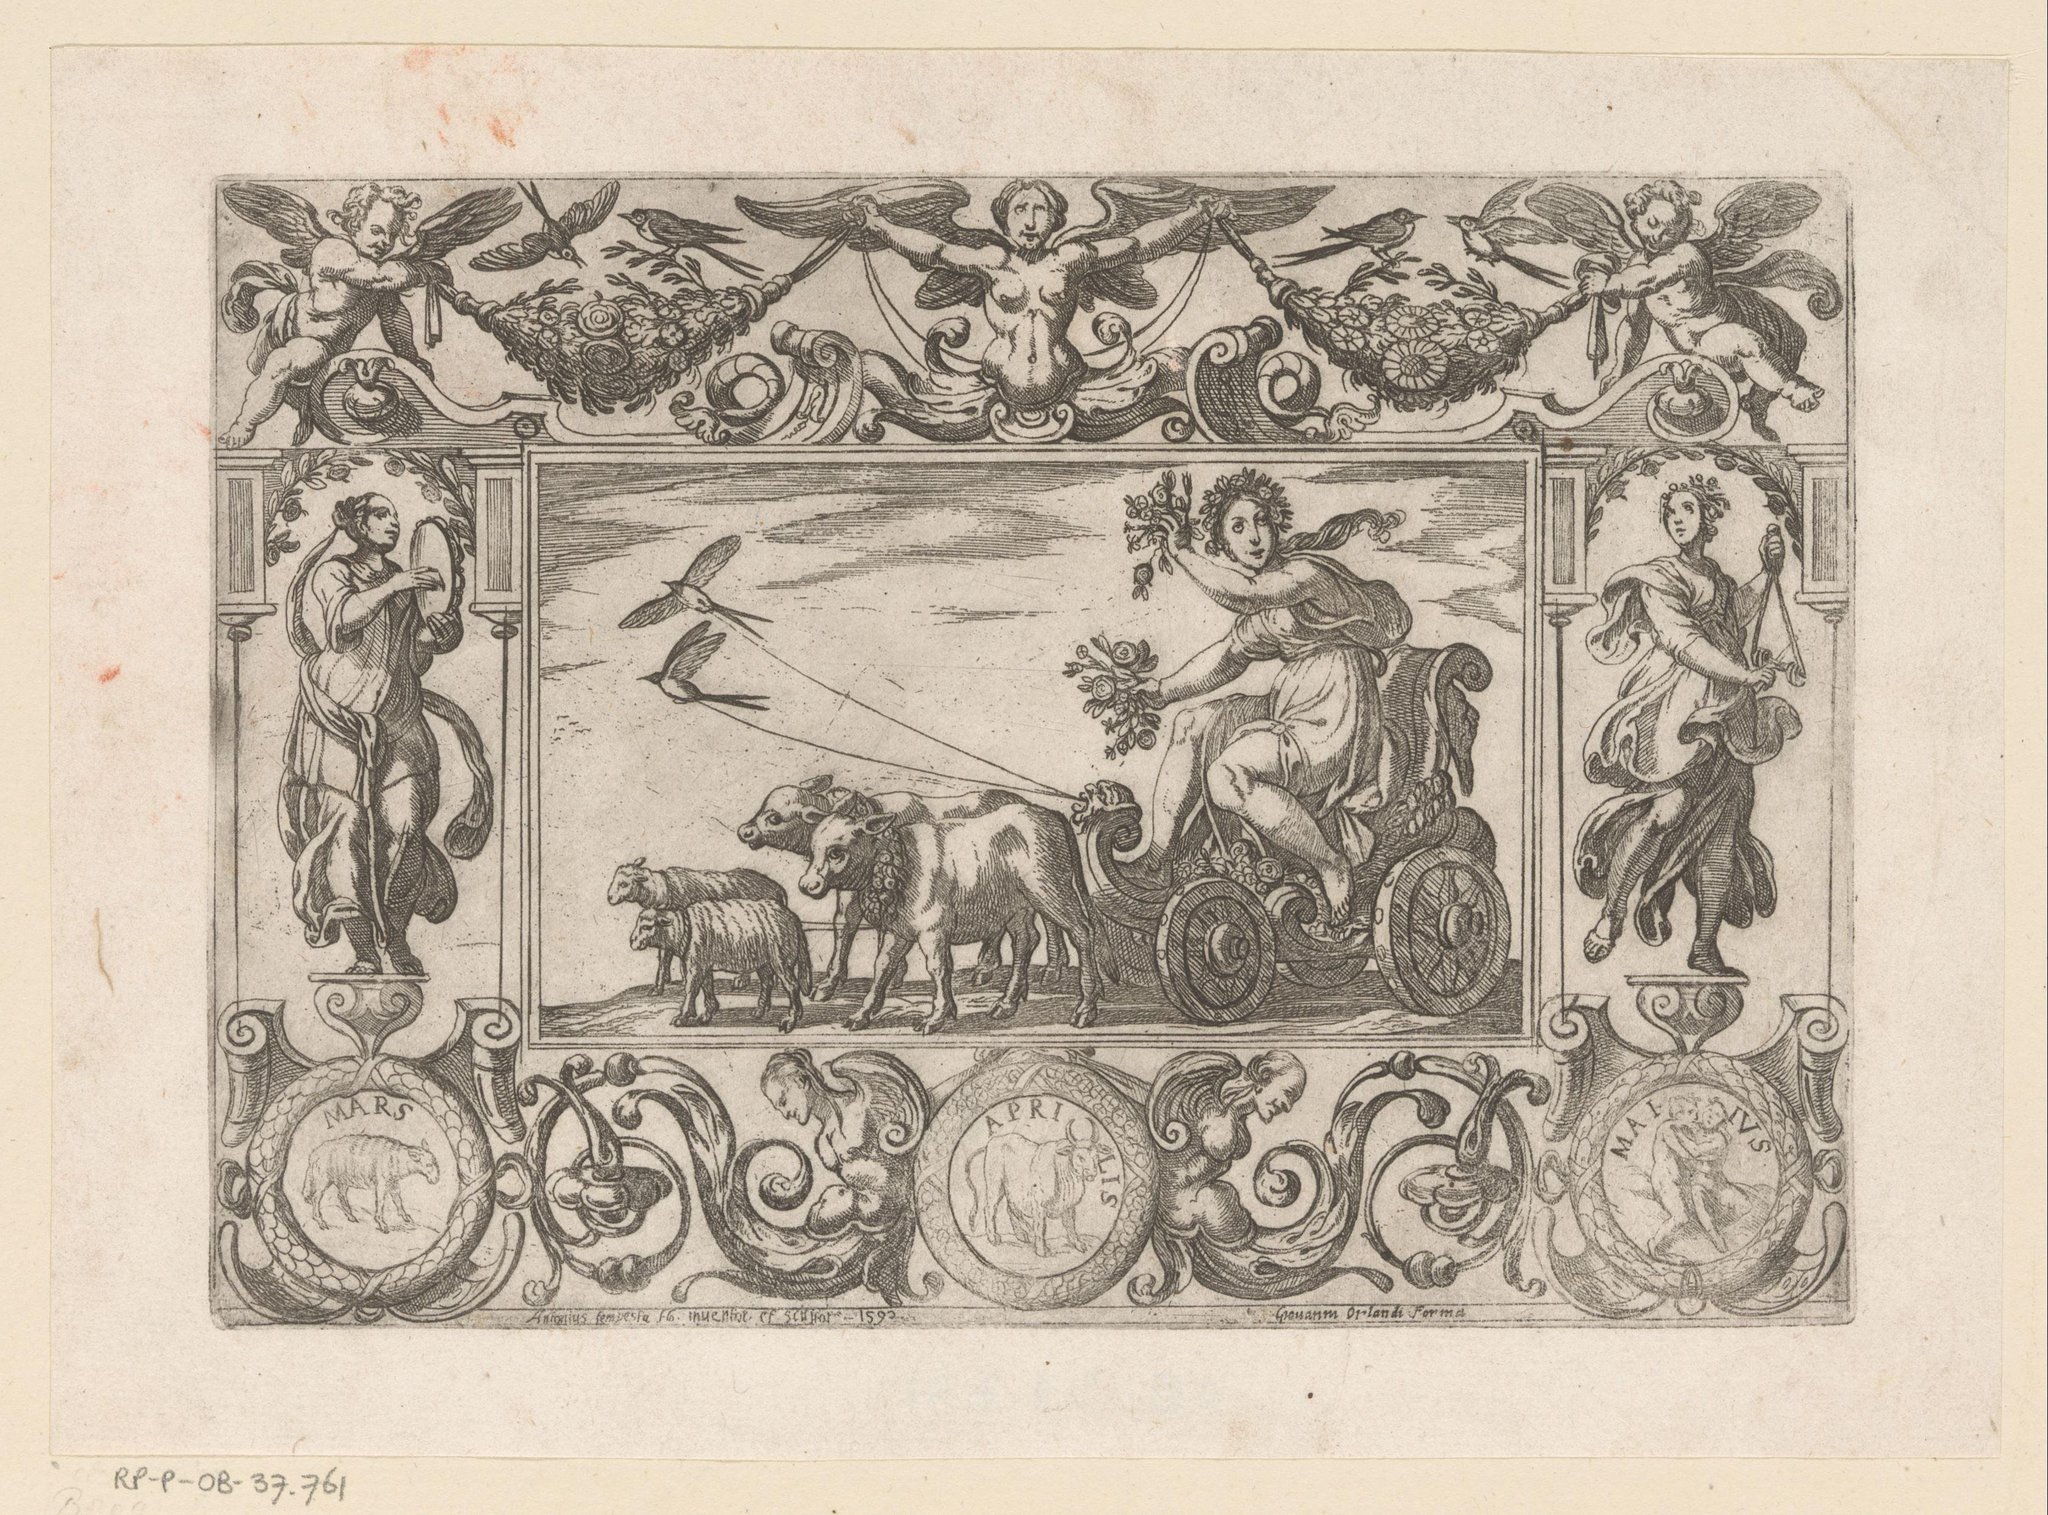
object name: print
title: Lente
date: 1592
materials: paper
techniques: etching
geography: rome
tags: summer, 'aestas'; 'estate' (ripa)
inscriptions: collector's mark: Lugt 240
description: Een vrouw met bloemen in haar handen op een wagen die wordt voortgetrokken door twee kalveren, twee lammetjes en twee zwaluwen. De voorstelling wordt omgeven door een ornamentele sierrand met medaillons met de maanden, vrouwen met muziekinstrumenten en gevleugelde figuren.